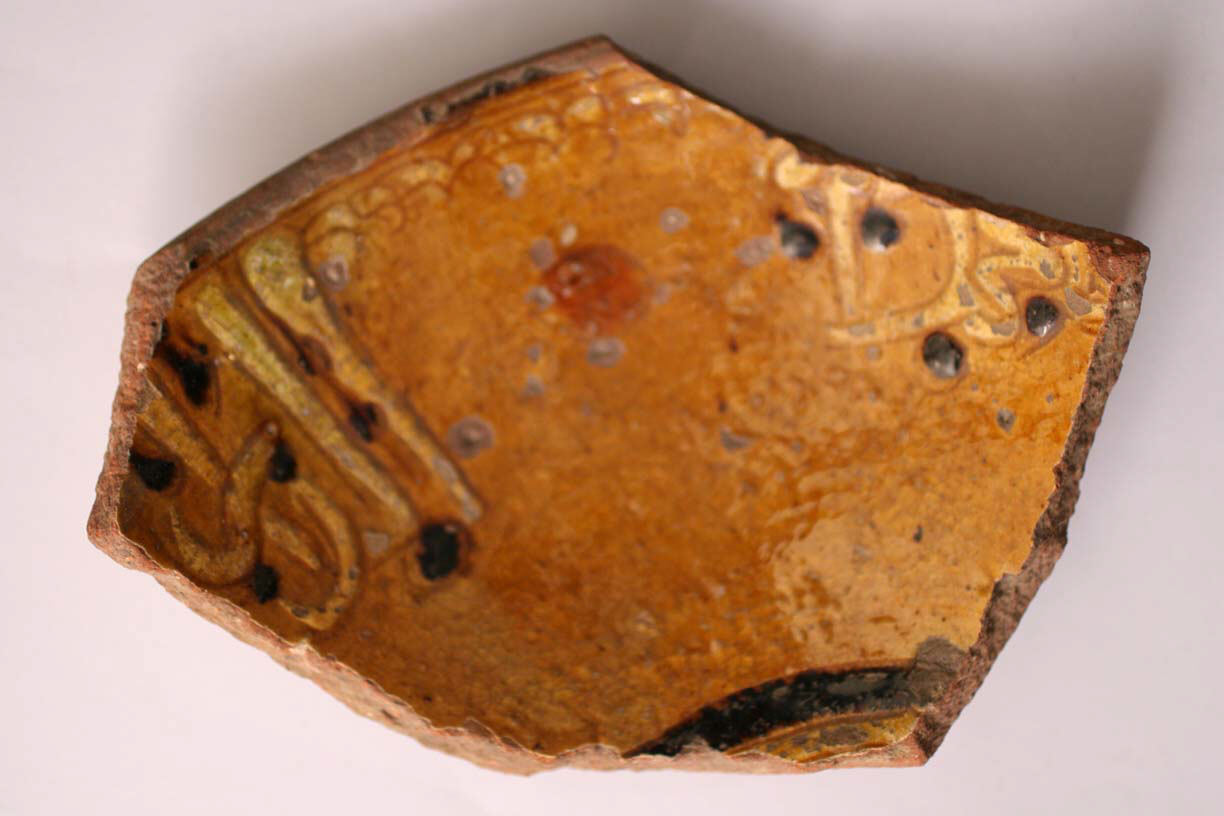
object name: ceramic fragment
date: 1301-1500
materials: earthenware, glaze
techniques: coloring, incising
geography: egypt